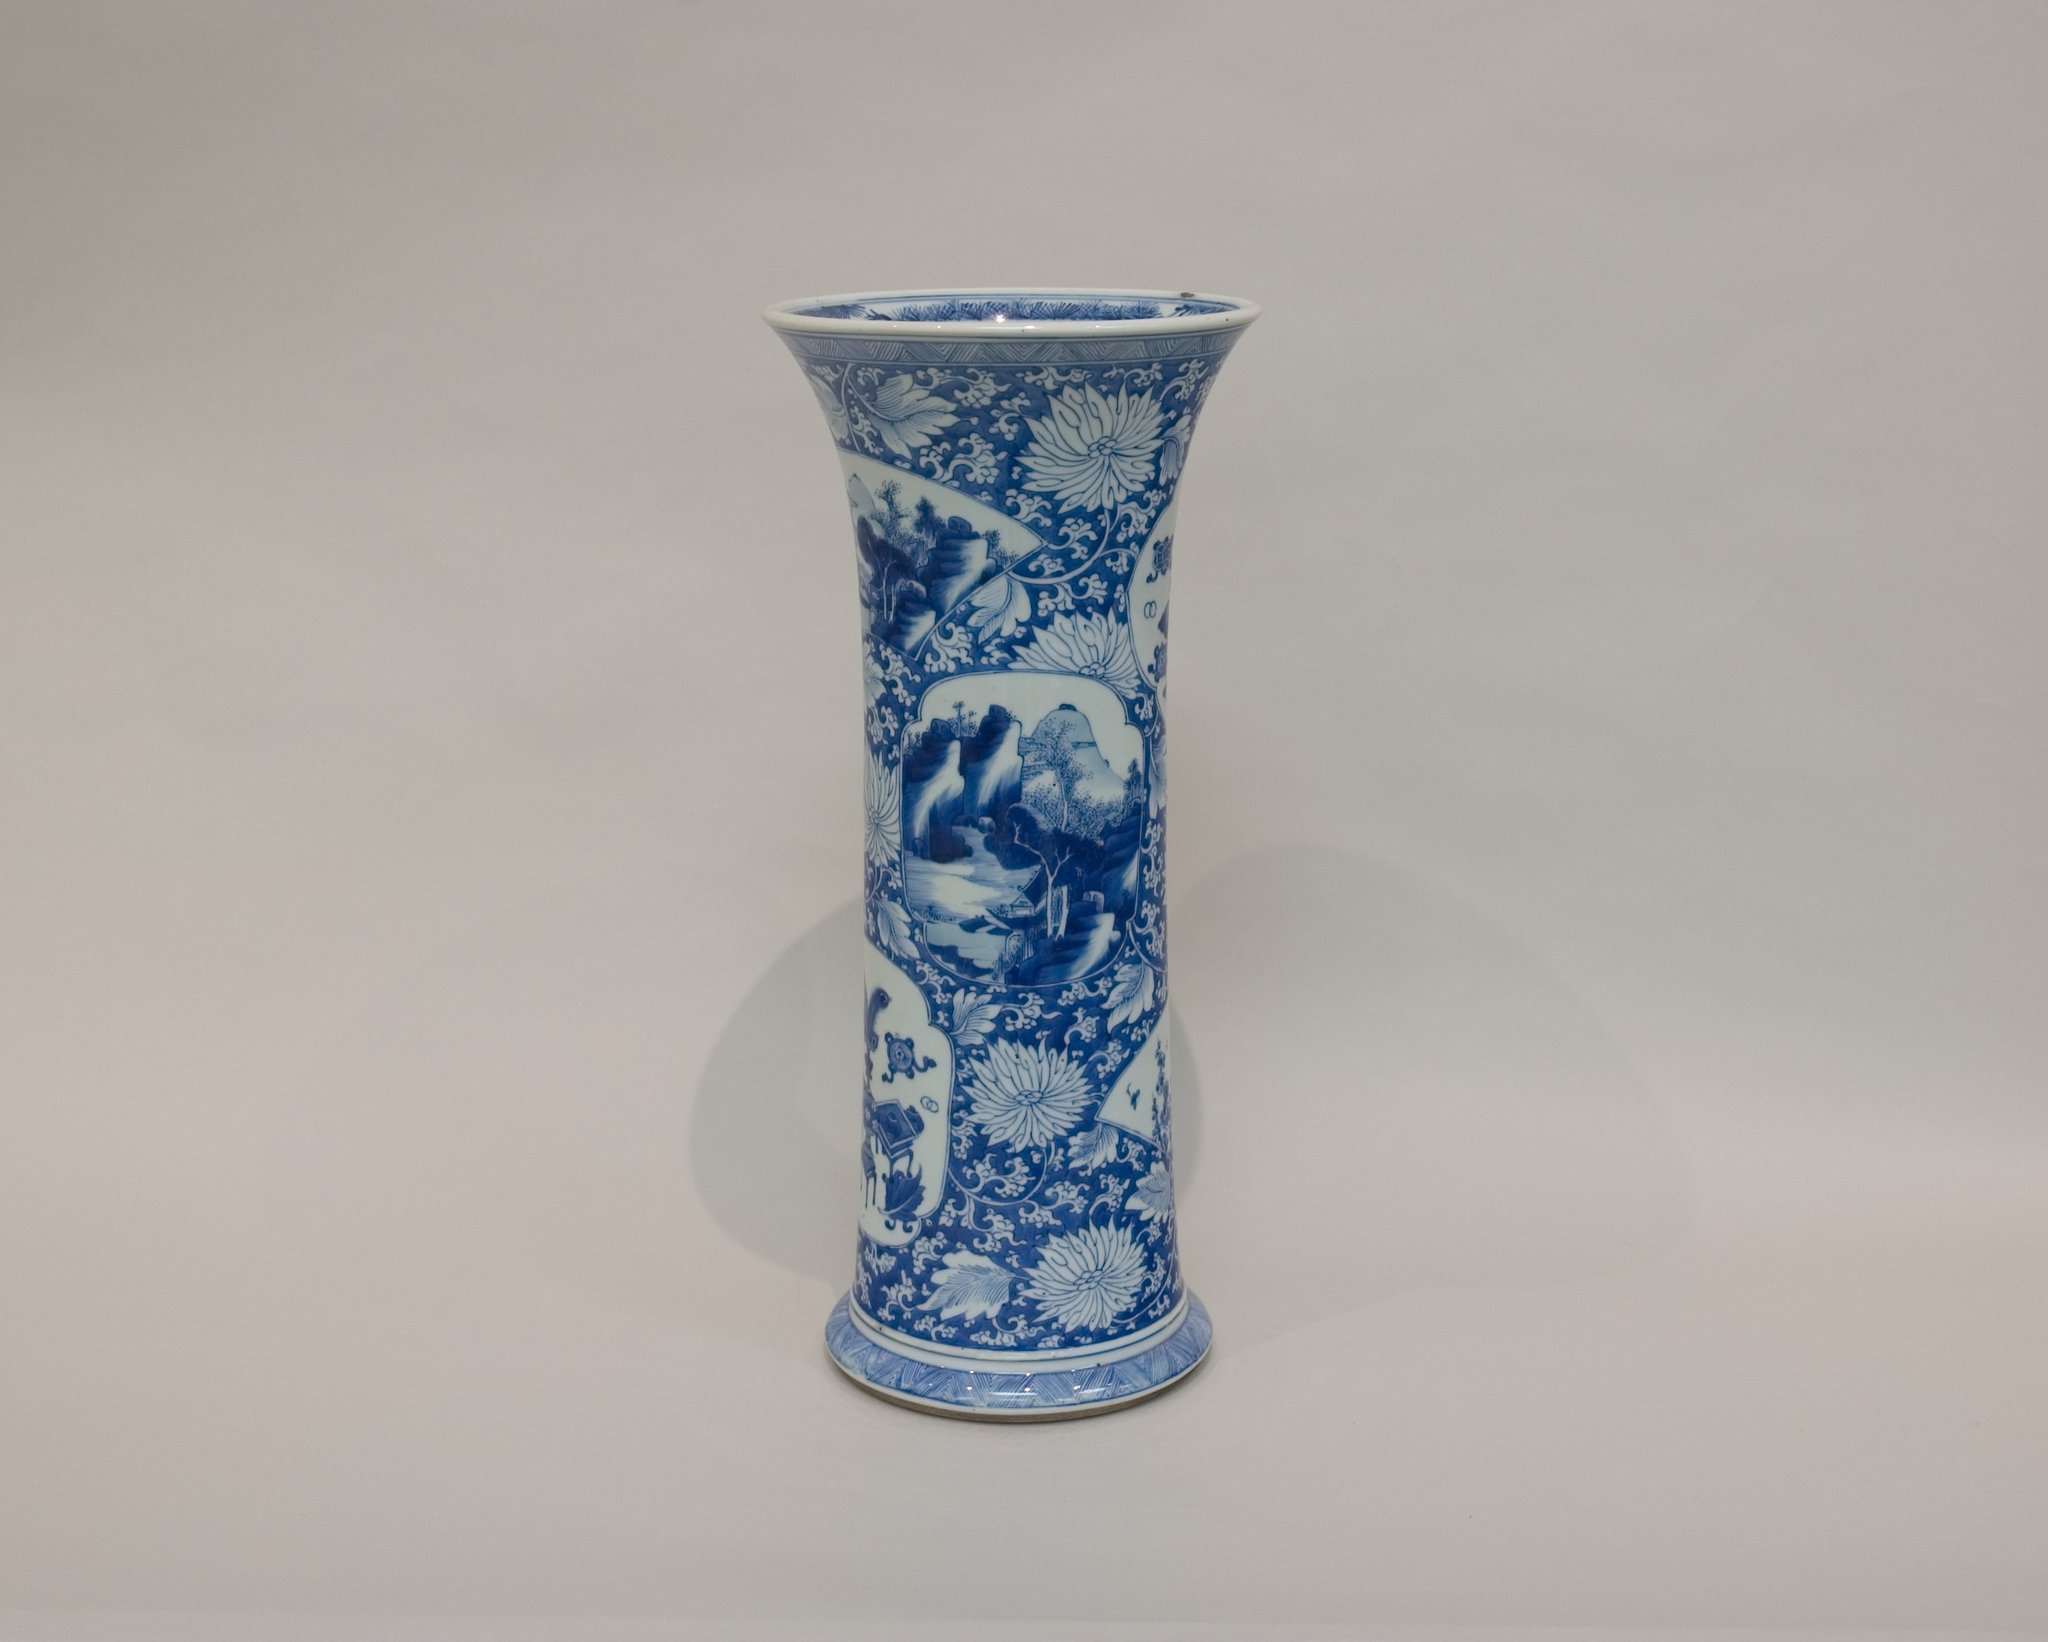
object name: vase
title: Vase with landscape and bird-and-flower scenes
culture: chinese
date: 1667-1733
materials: cobalt, porcelain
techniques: painting, underglaze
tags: flowers,landscapes